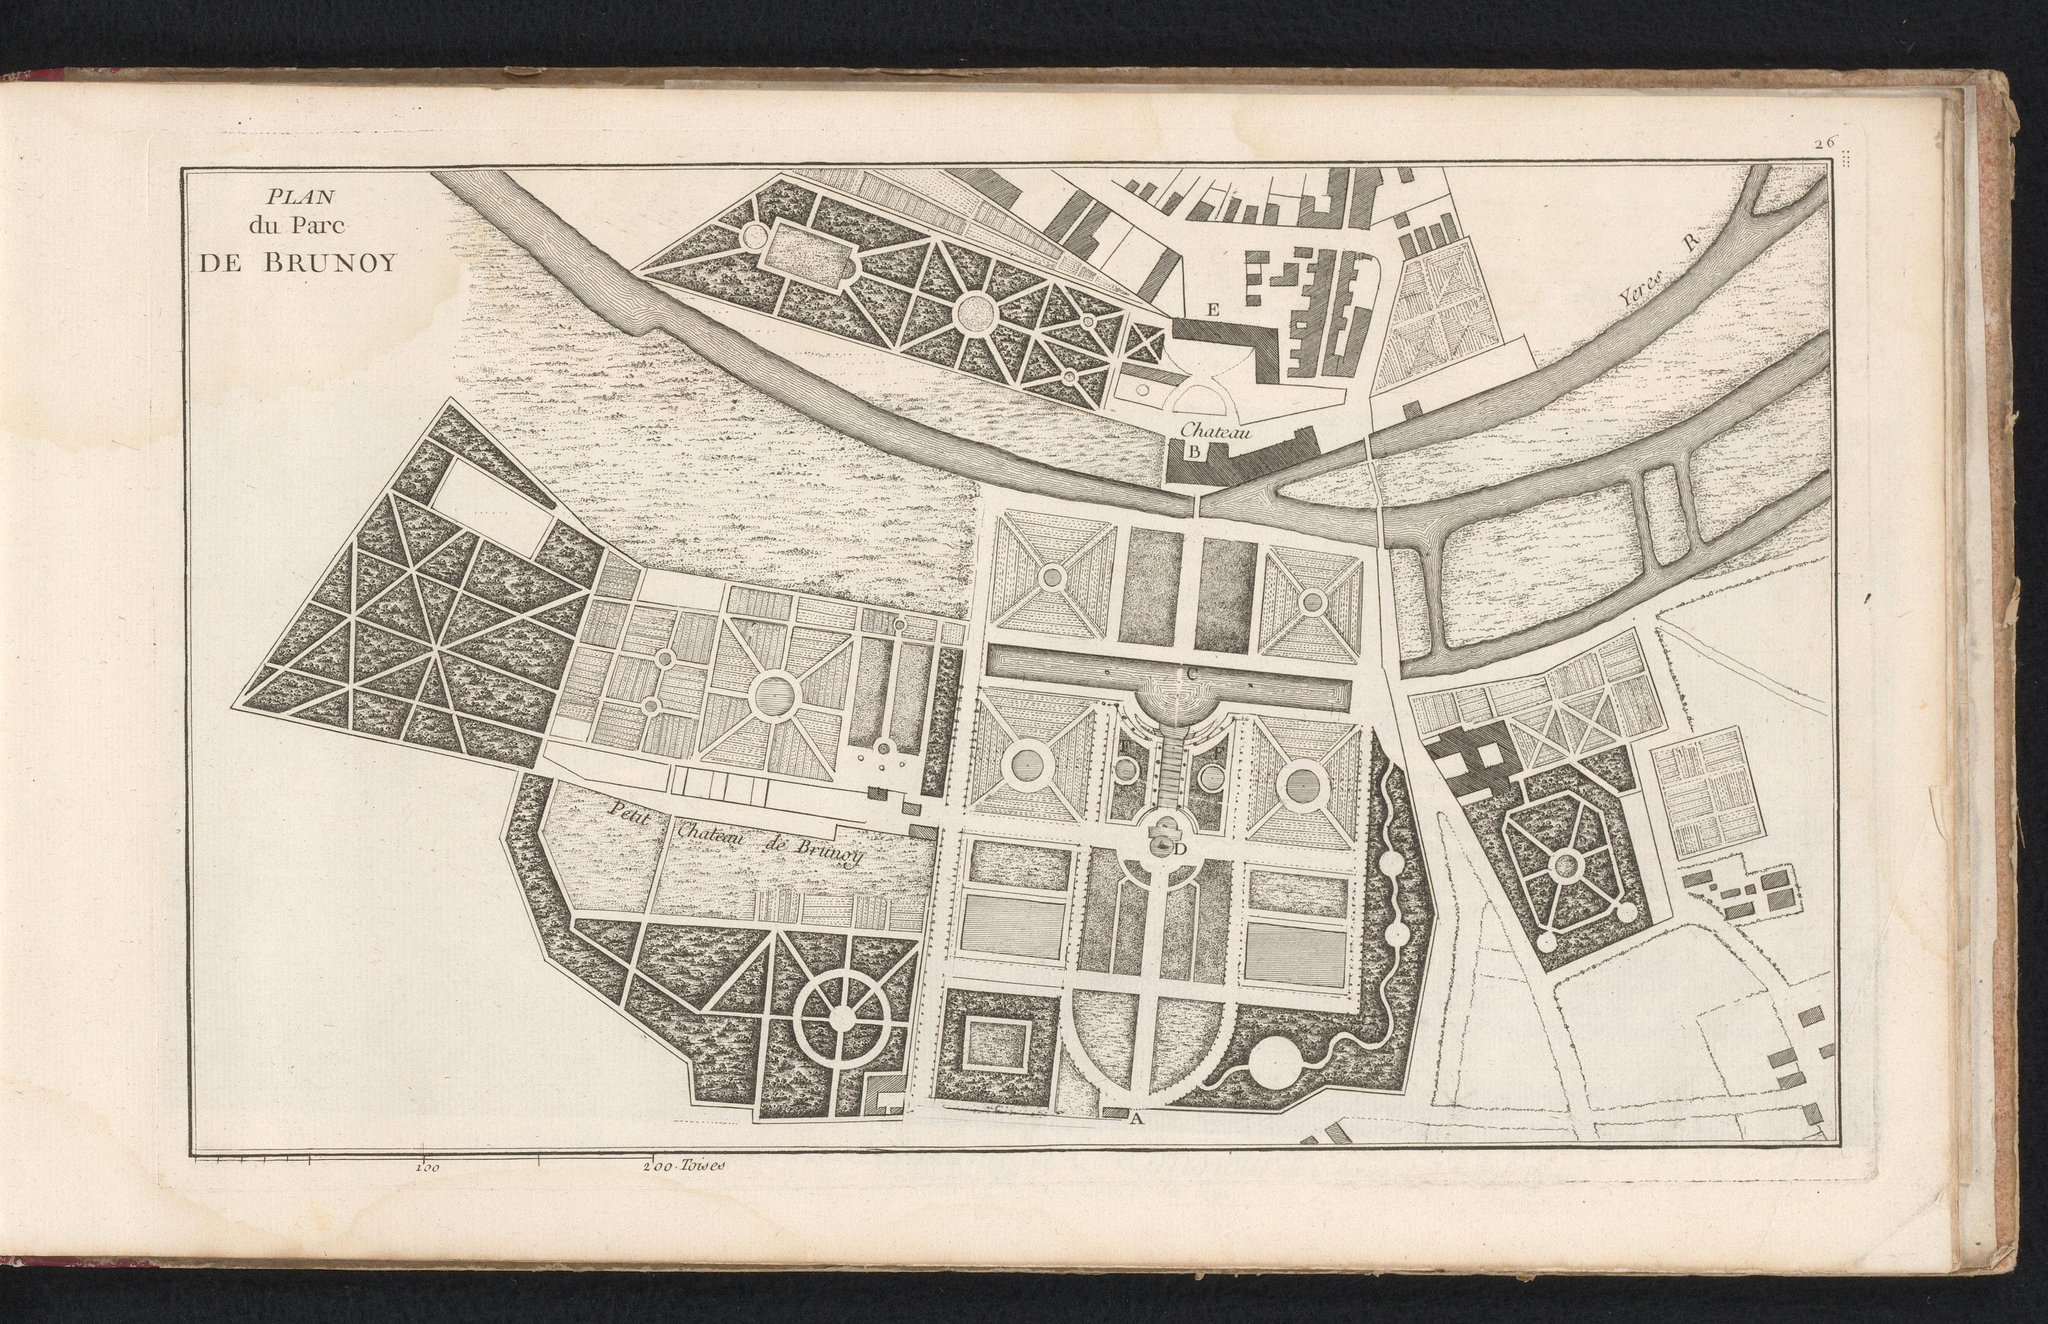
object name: print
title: Jardins anglo-chinois à la mode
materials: paper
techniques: engraving, etching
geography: paris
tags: plan, map of garden, castle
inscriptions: collector's mark: Lugt 2228, collector's mark: Lugt 2760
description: De serie 'Jardins anglo-chinois à la mode' verscheen in totaal in 21 zogeheten 'cahiers' (afleveringen). De huidige prent komt uit het achtste 'cahier'. Het Rijksmuseum Amsterdam bezit drie banden met daarin in totaal zes 'cahiers' van deze reeks. In de documentatie wordt verwezen naar een in de bibliotheek van het Rijksmuseum Amsterdam aanwezige facsimile van het complete werk.